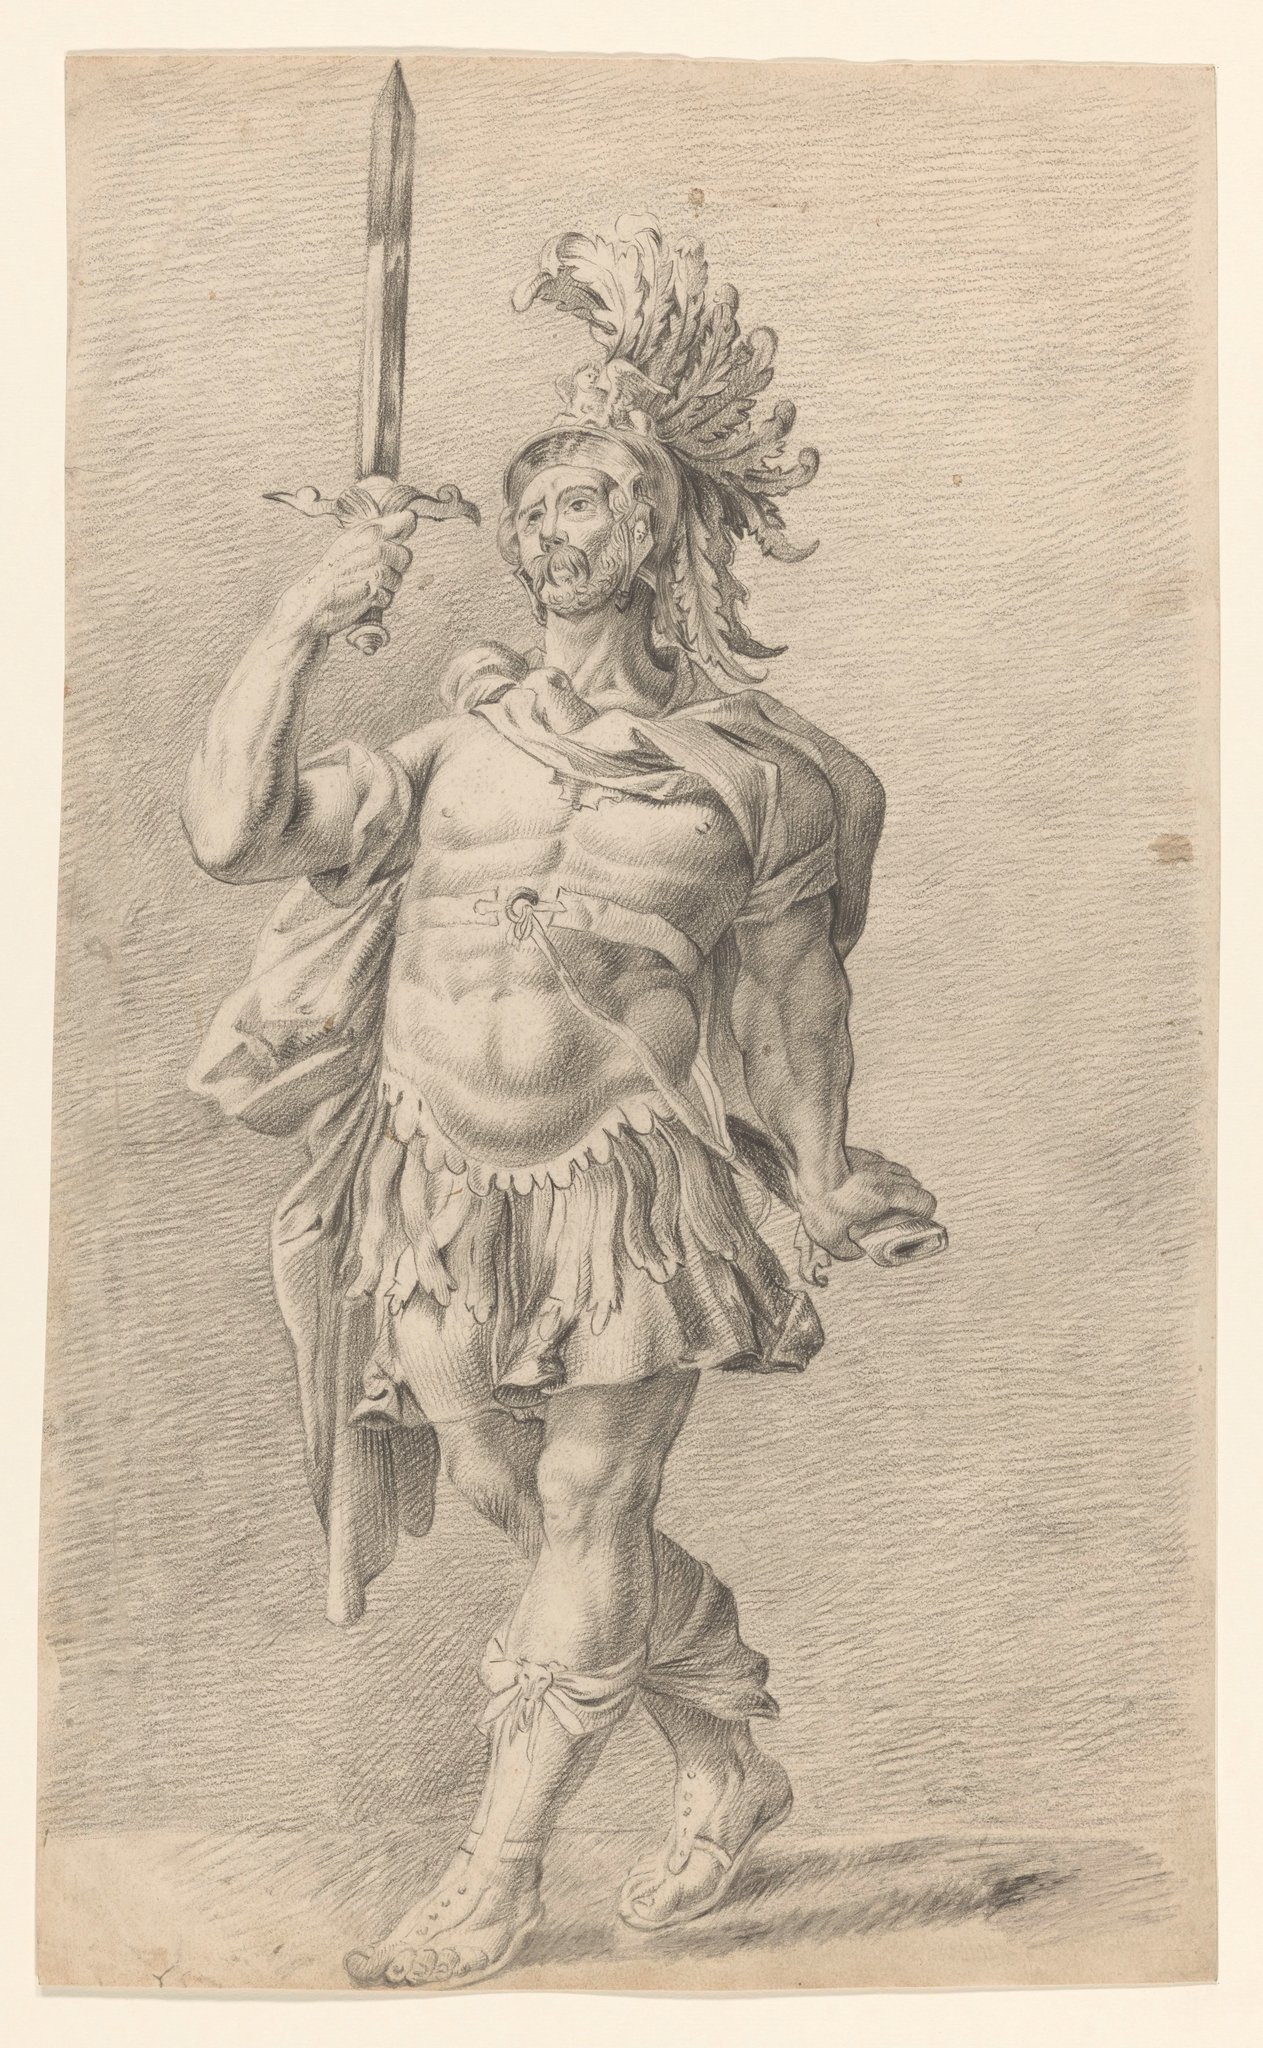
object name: drawing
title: Publius Horatius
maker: johannes tavenraat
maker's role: draughtsman, painter, print maker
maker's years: 1809-1881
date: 1827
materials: chalk, paper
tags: venosa, rome, horatius, (story of) the horatii, three brothers from rome